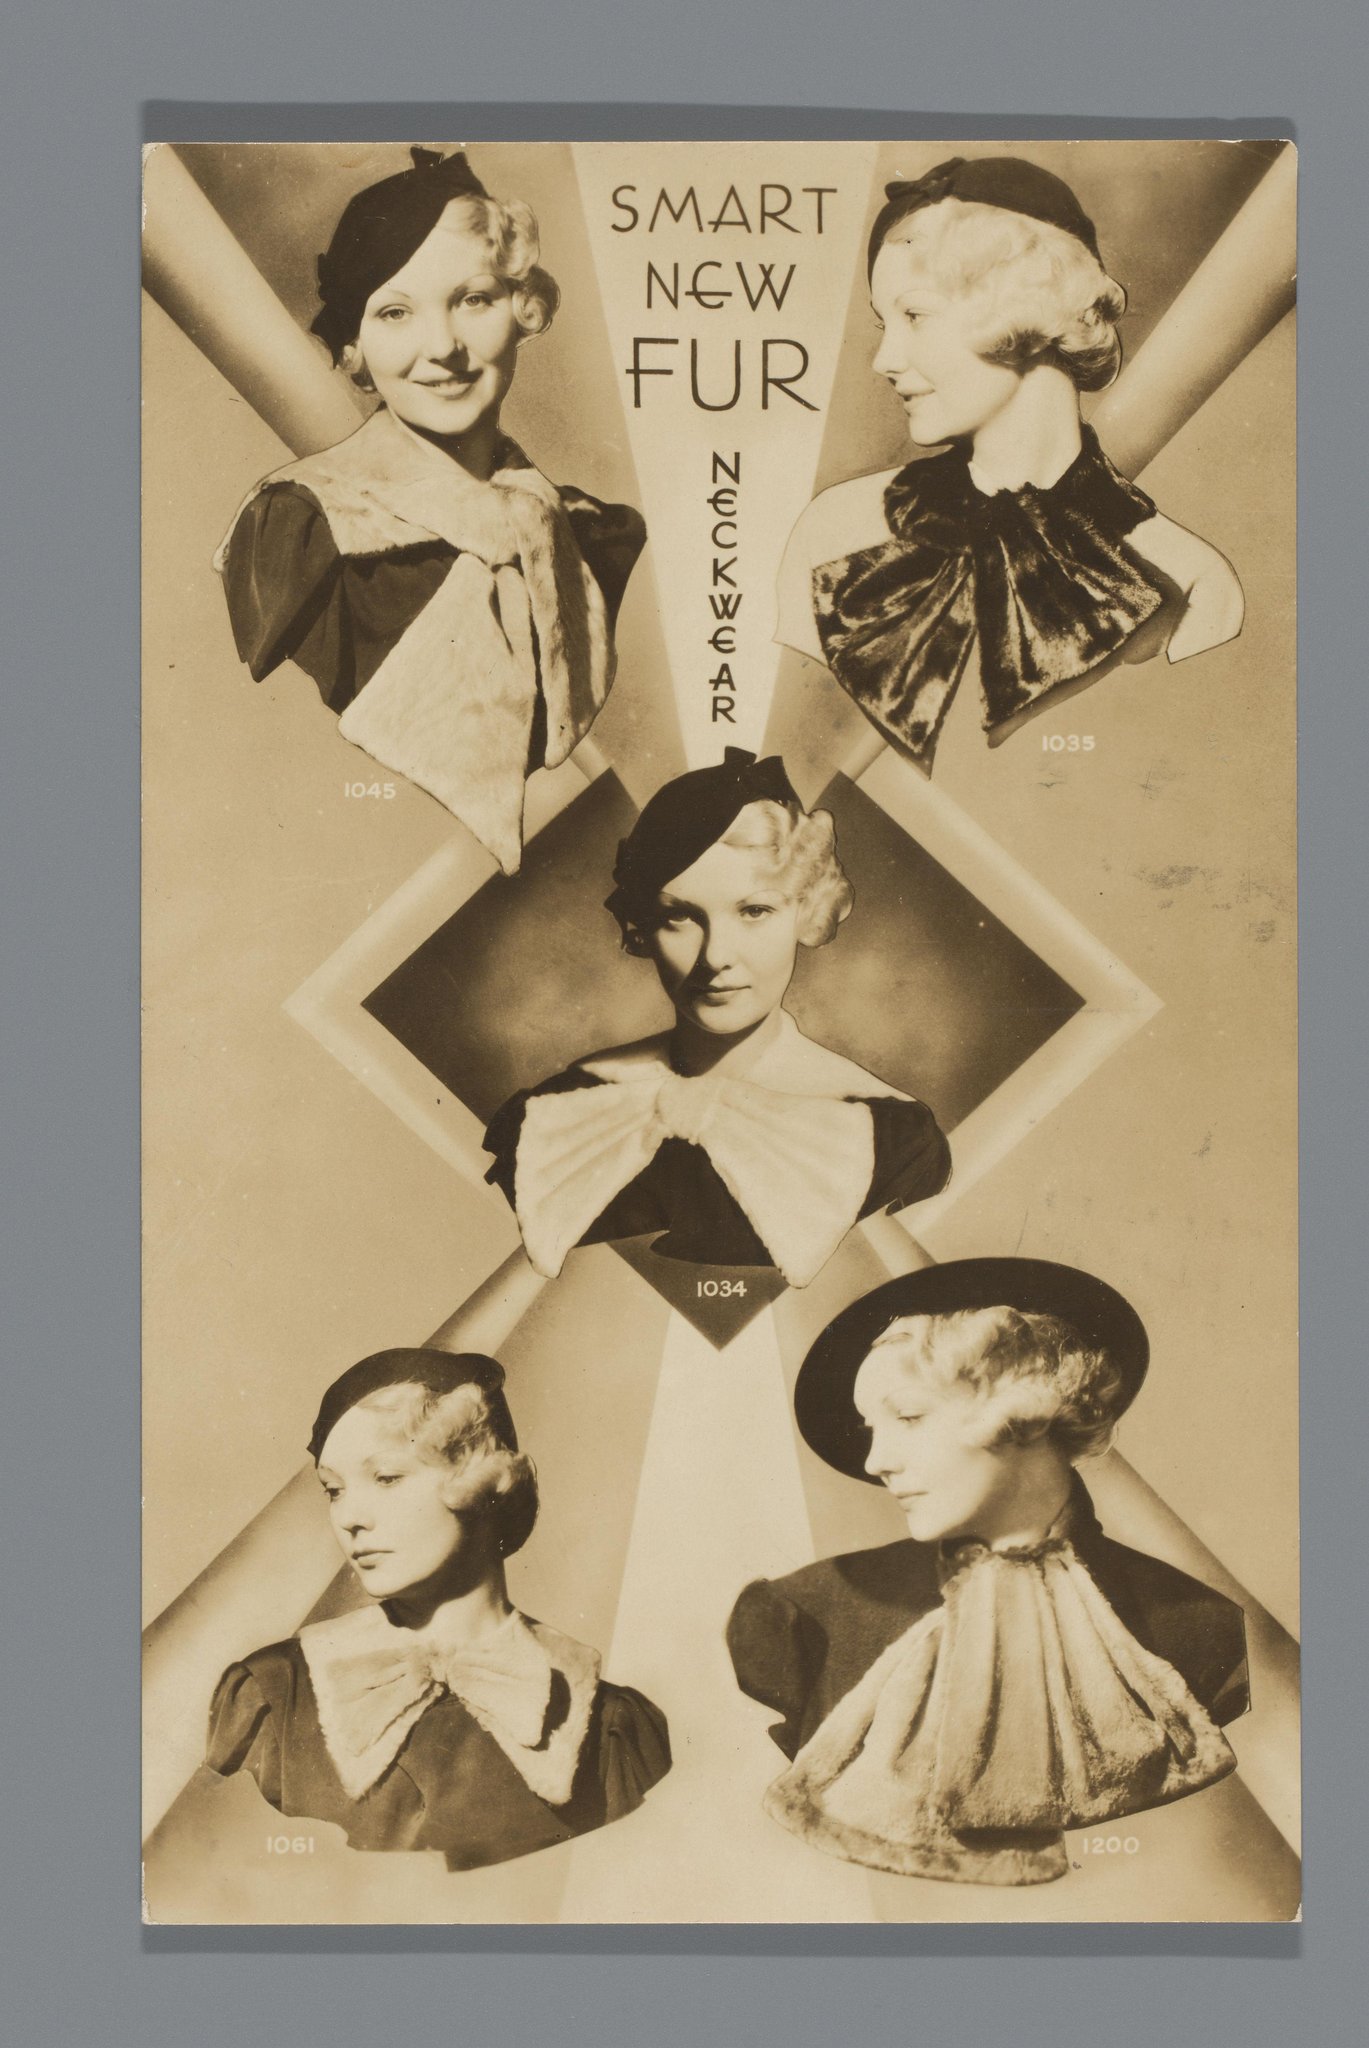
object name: ansichtkaart, prentbriefkaart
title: Reclame voor bontkragen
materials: photographic support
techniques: gelatin silver print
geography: new york city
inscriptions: inscription: ‘SMART / NEW / FUR / NECKWEAR (met productnummers)’, inscription: ‘[omschrijving van de bontkragen] Groslyn Fur Trading Co. Inc. / 130 W. 30th STREET / NEW YORK. N.Y.’, stamp: ‘1934’